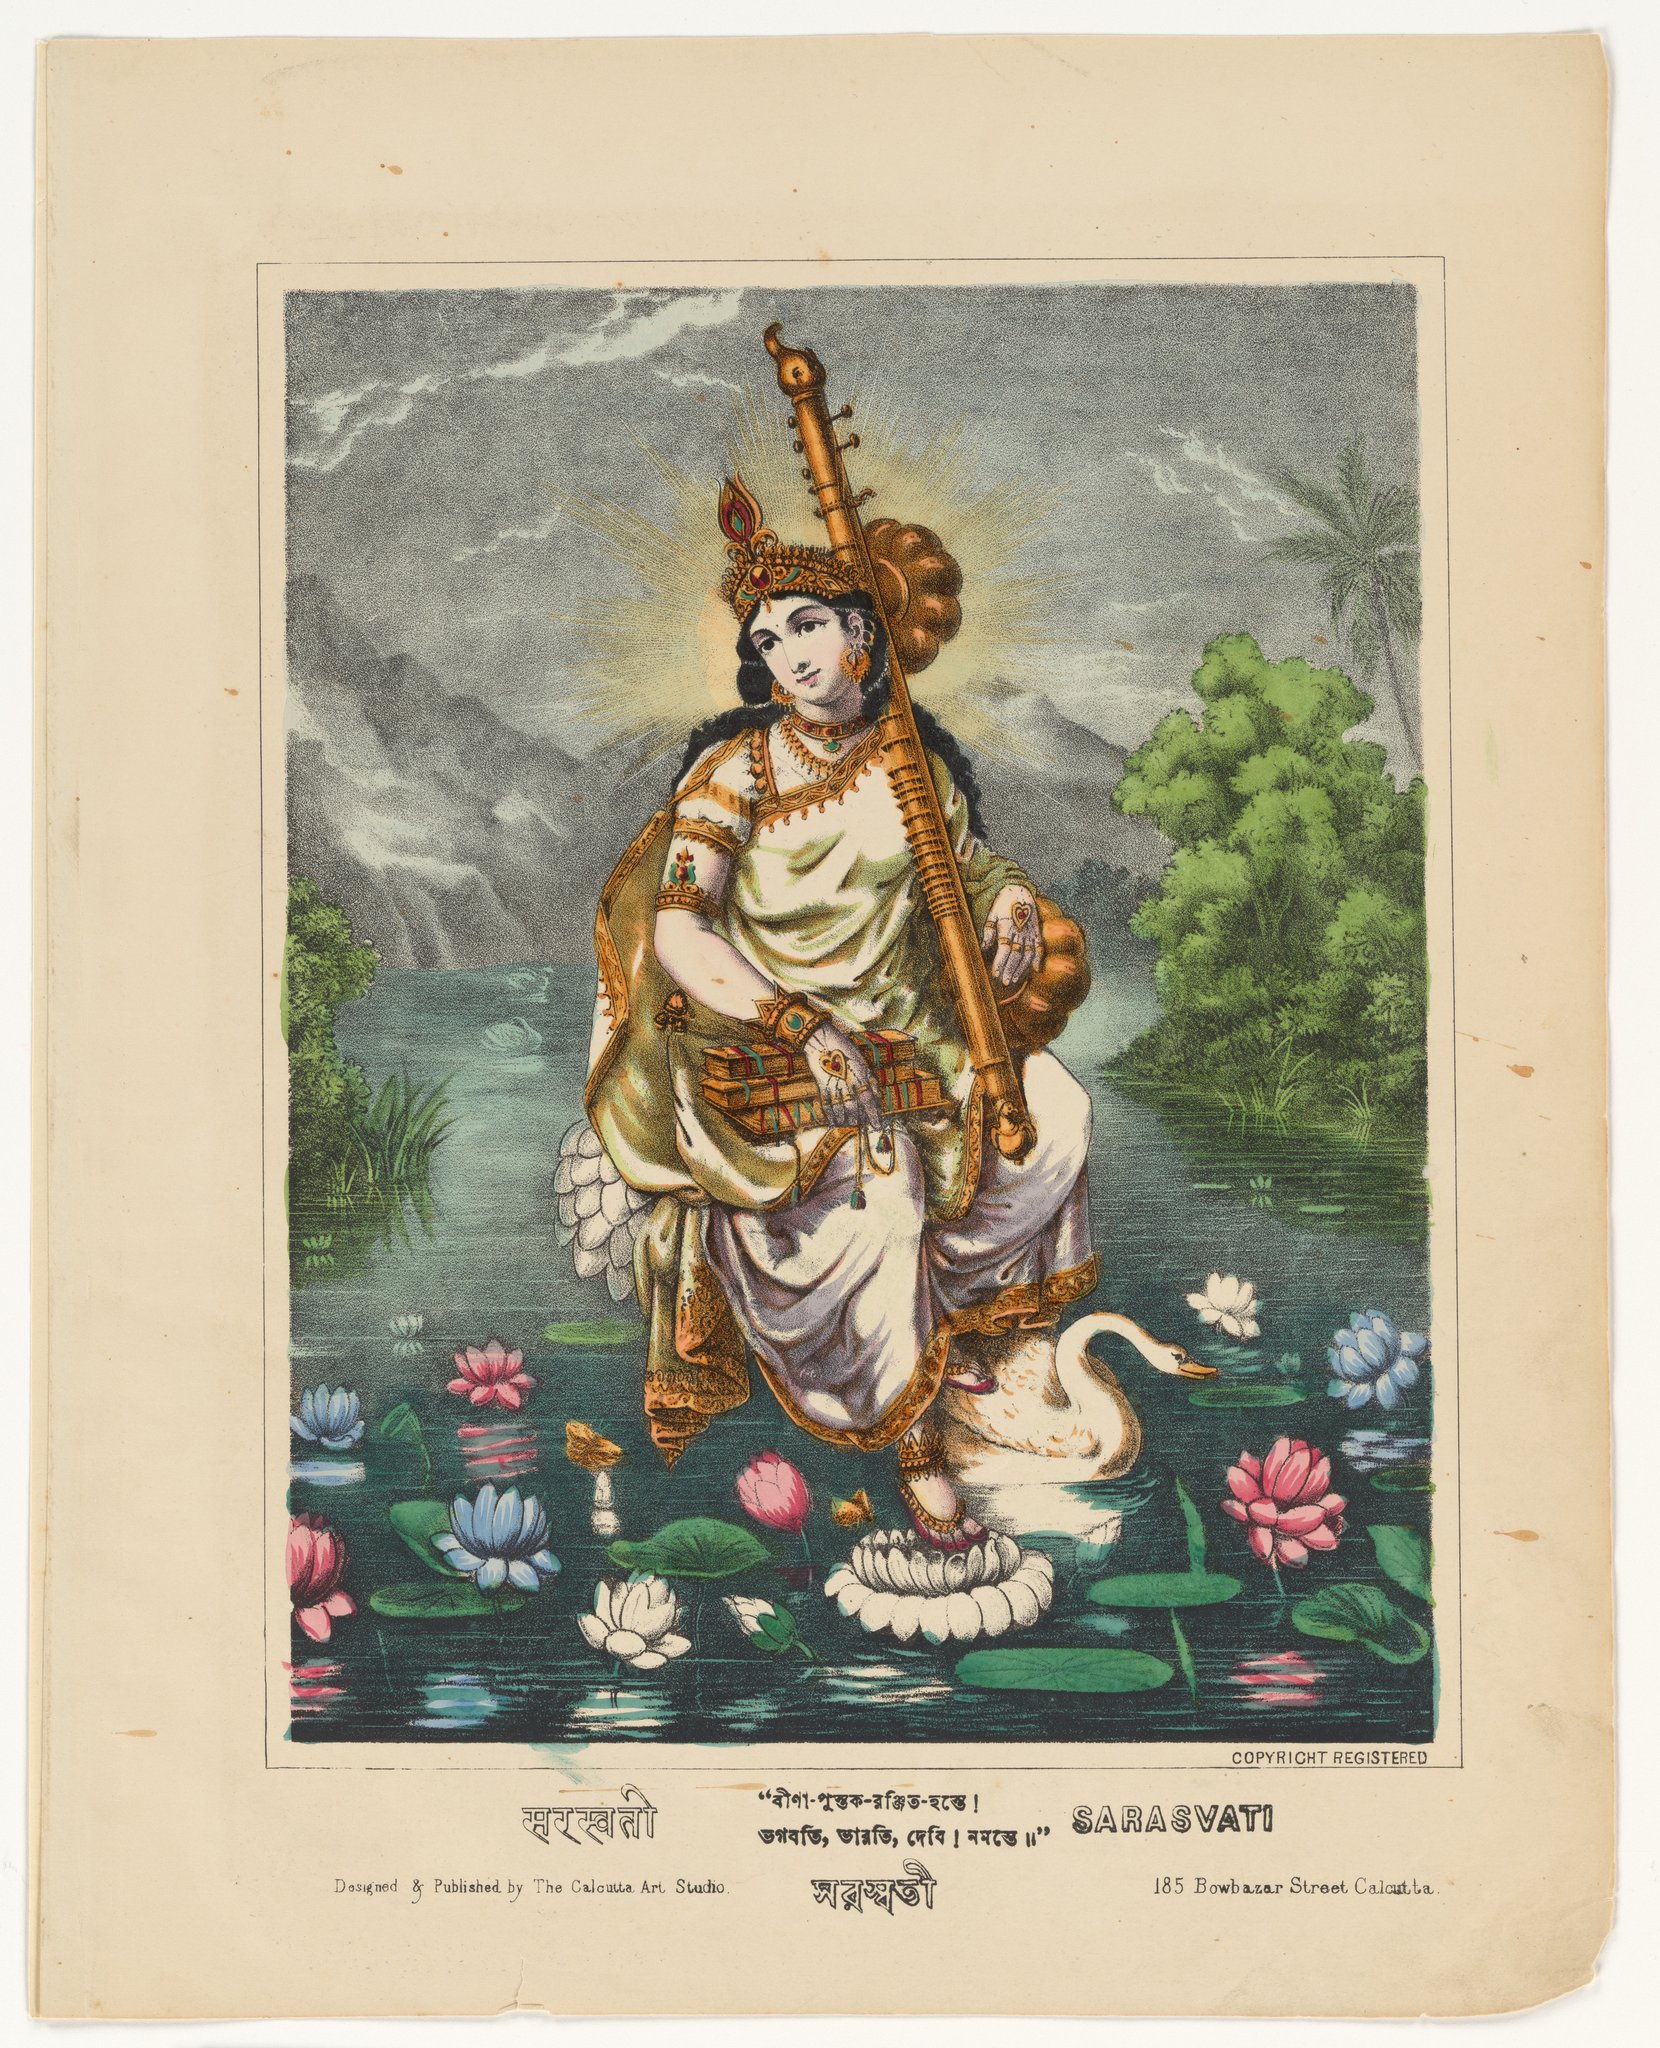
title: Goddess Sarasvati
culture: west bengali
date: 1878-1883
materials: glaze, watercolor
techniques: hand coloring, lithograph, printing